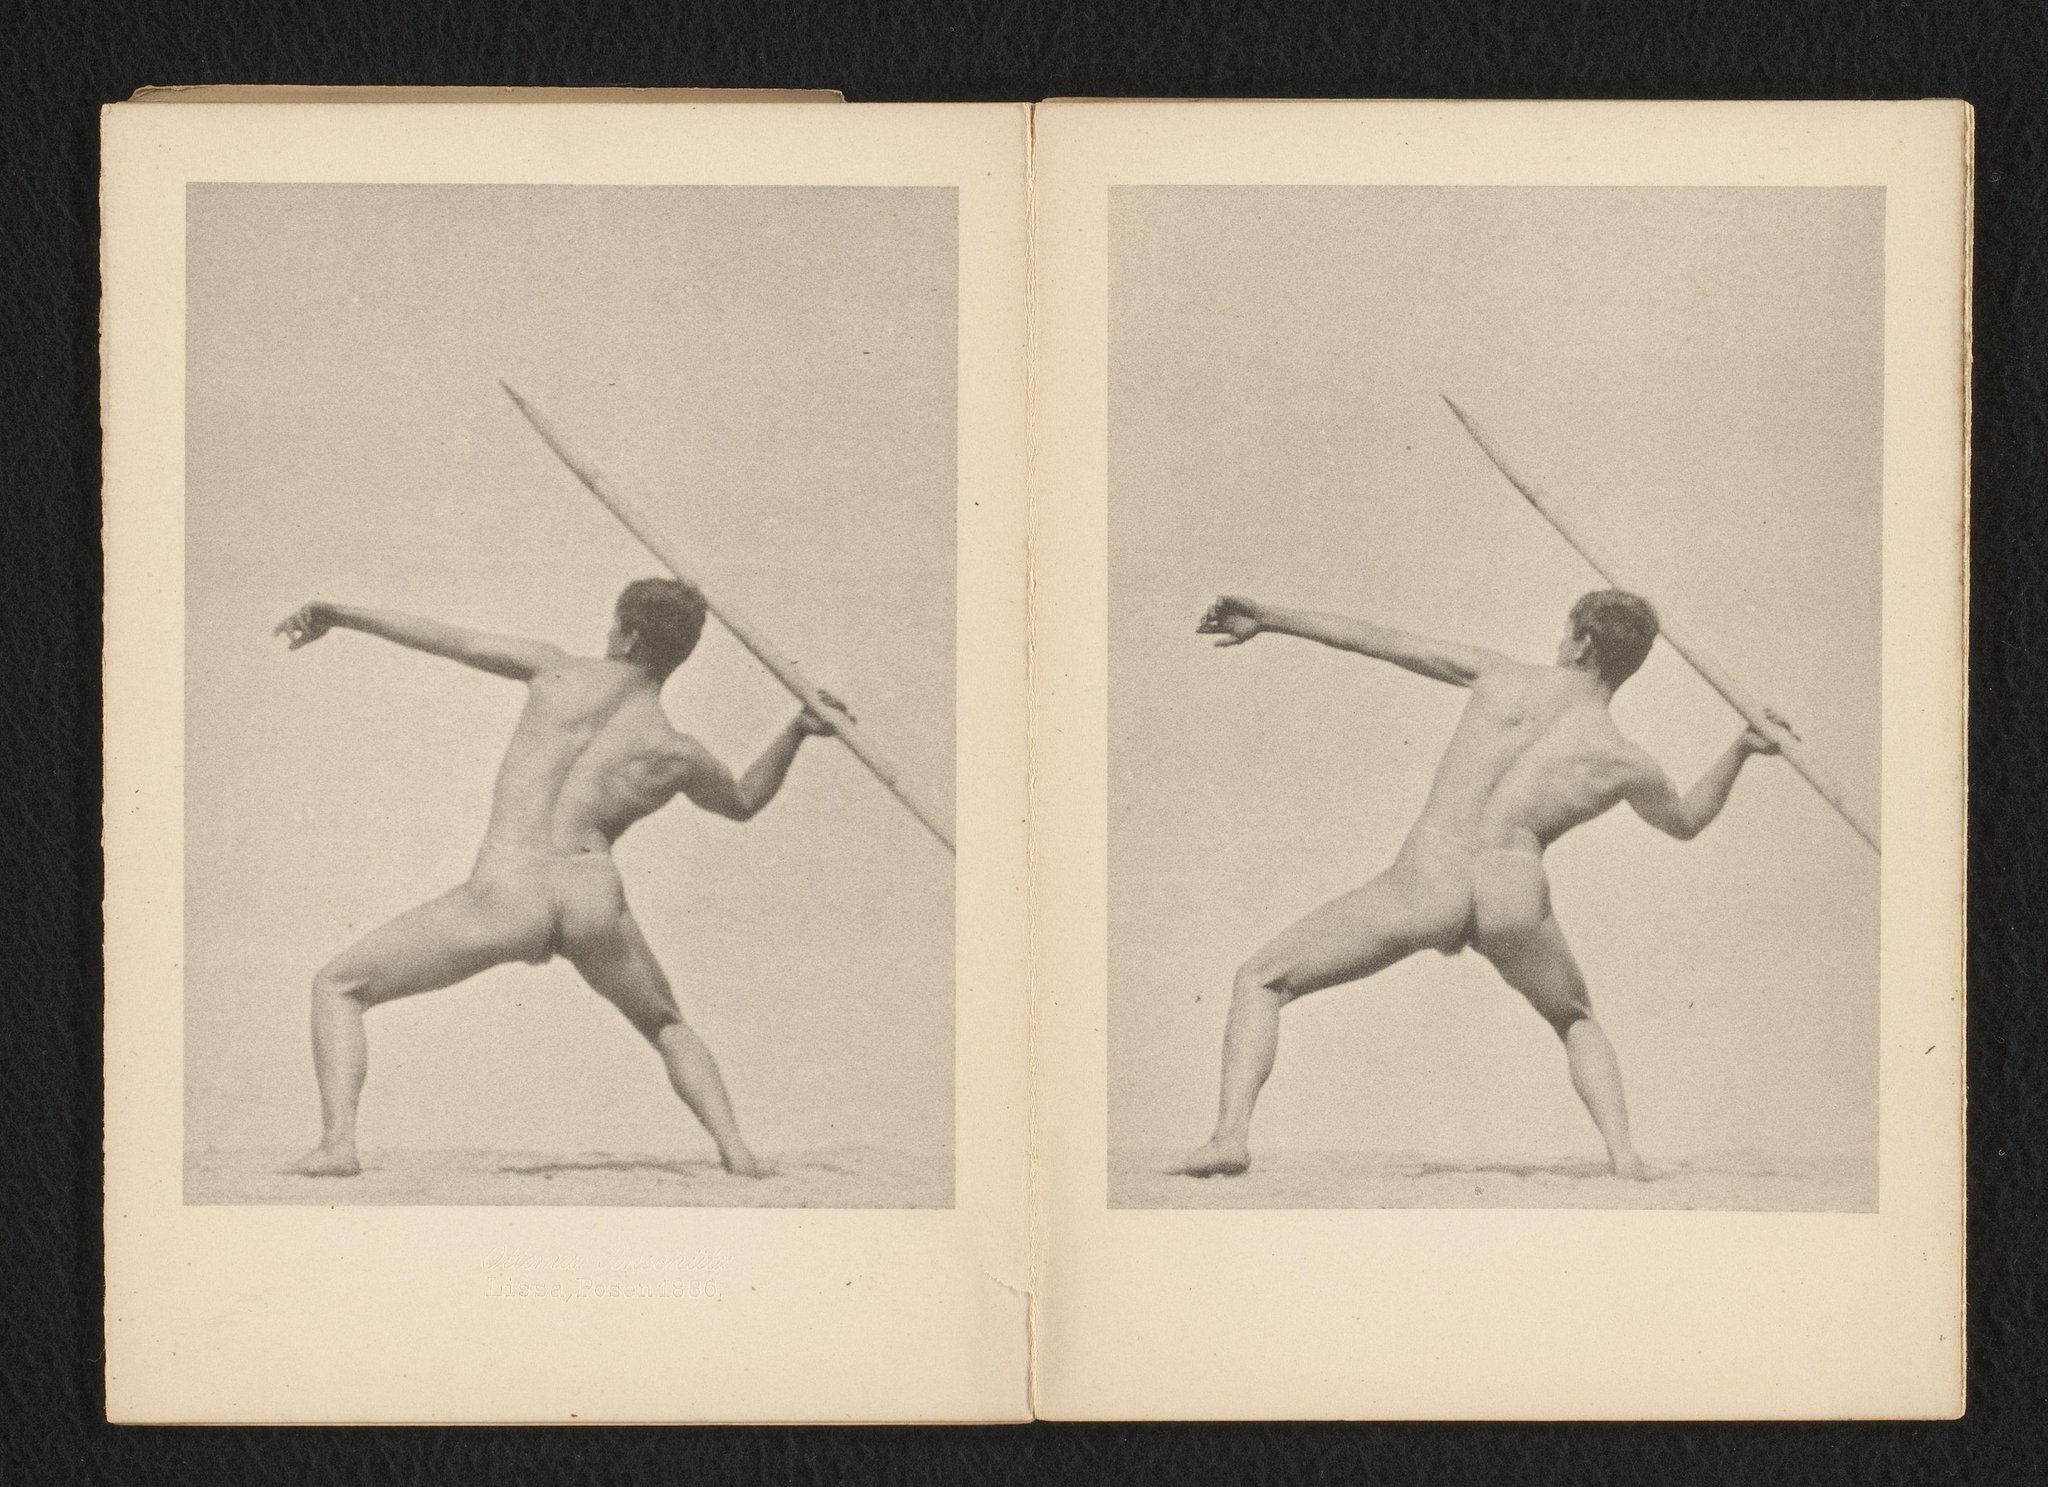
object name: page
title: Man werpt een speer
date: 1886-1887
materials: paper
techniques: photograph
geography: lisse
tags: casting weapons: spear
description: Onderdeel van een sequentie van twaalf opnamen.